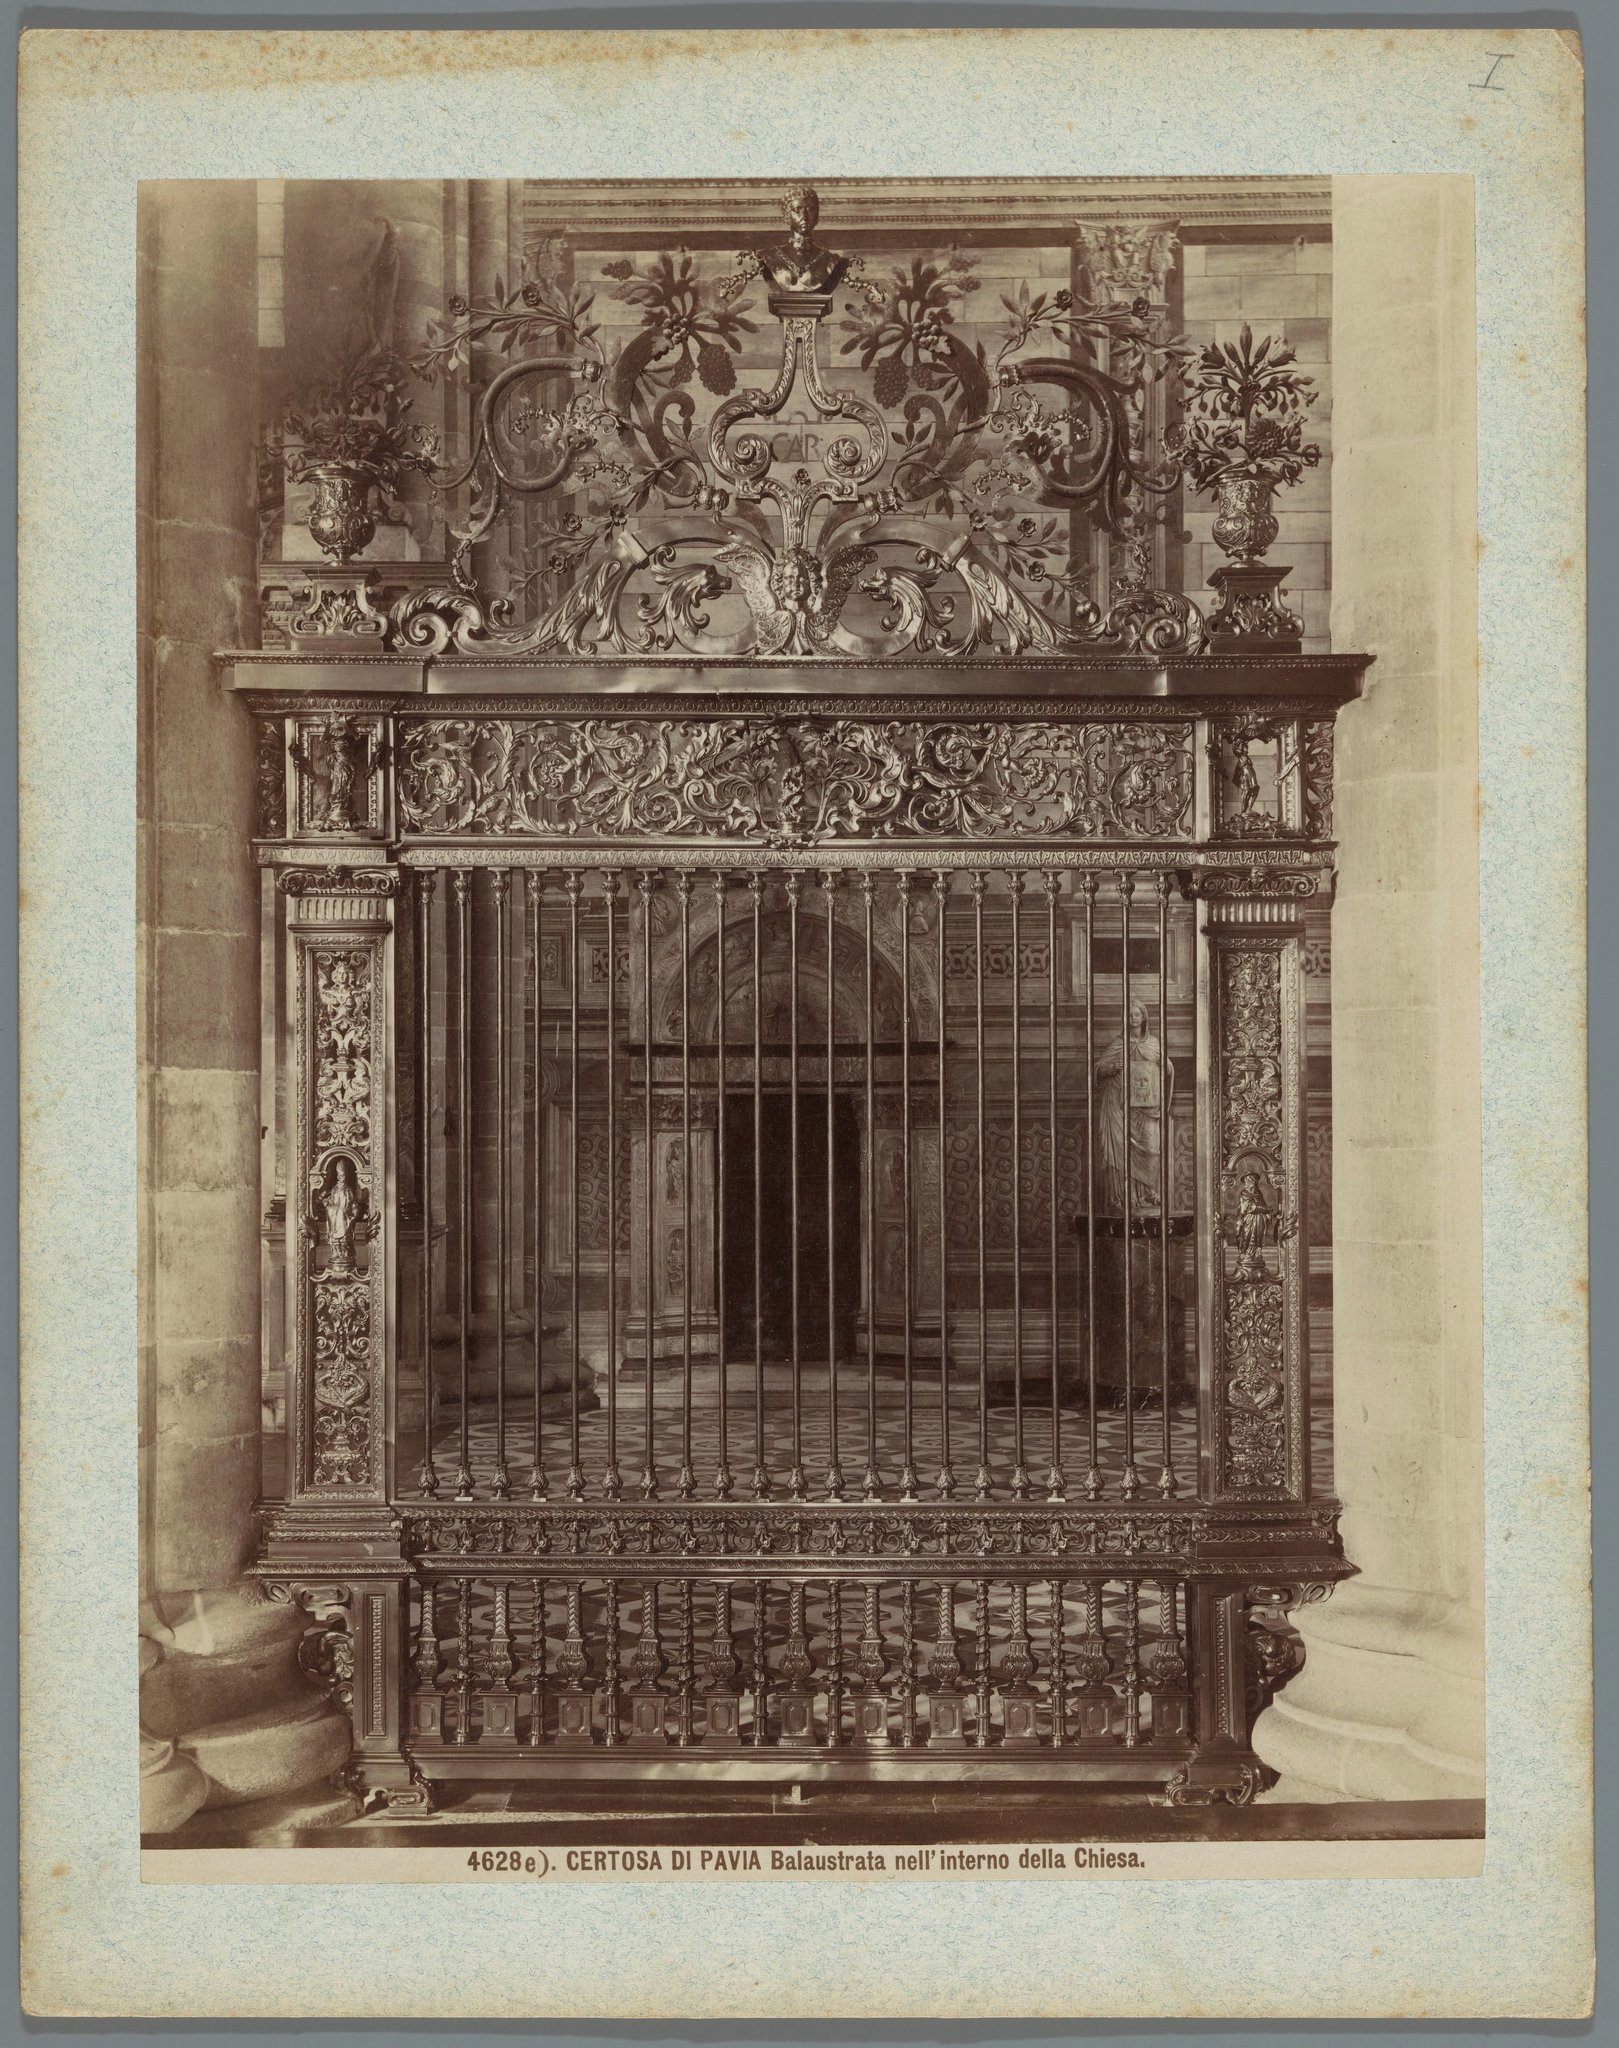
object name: photograph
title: CERTOSA DI PAVIA Balaustrata nell'interno della Chiesa.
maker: Anonymous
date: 1875-1900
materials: cardboard, photographic support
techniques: albumen print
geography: certosa di pavia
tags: fence, wall, paling, balustrade, interior of church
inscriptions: collector's mark: Lugt 3937, number: ‘4682 e ).’